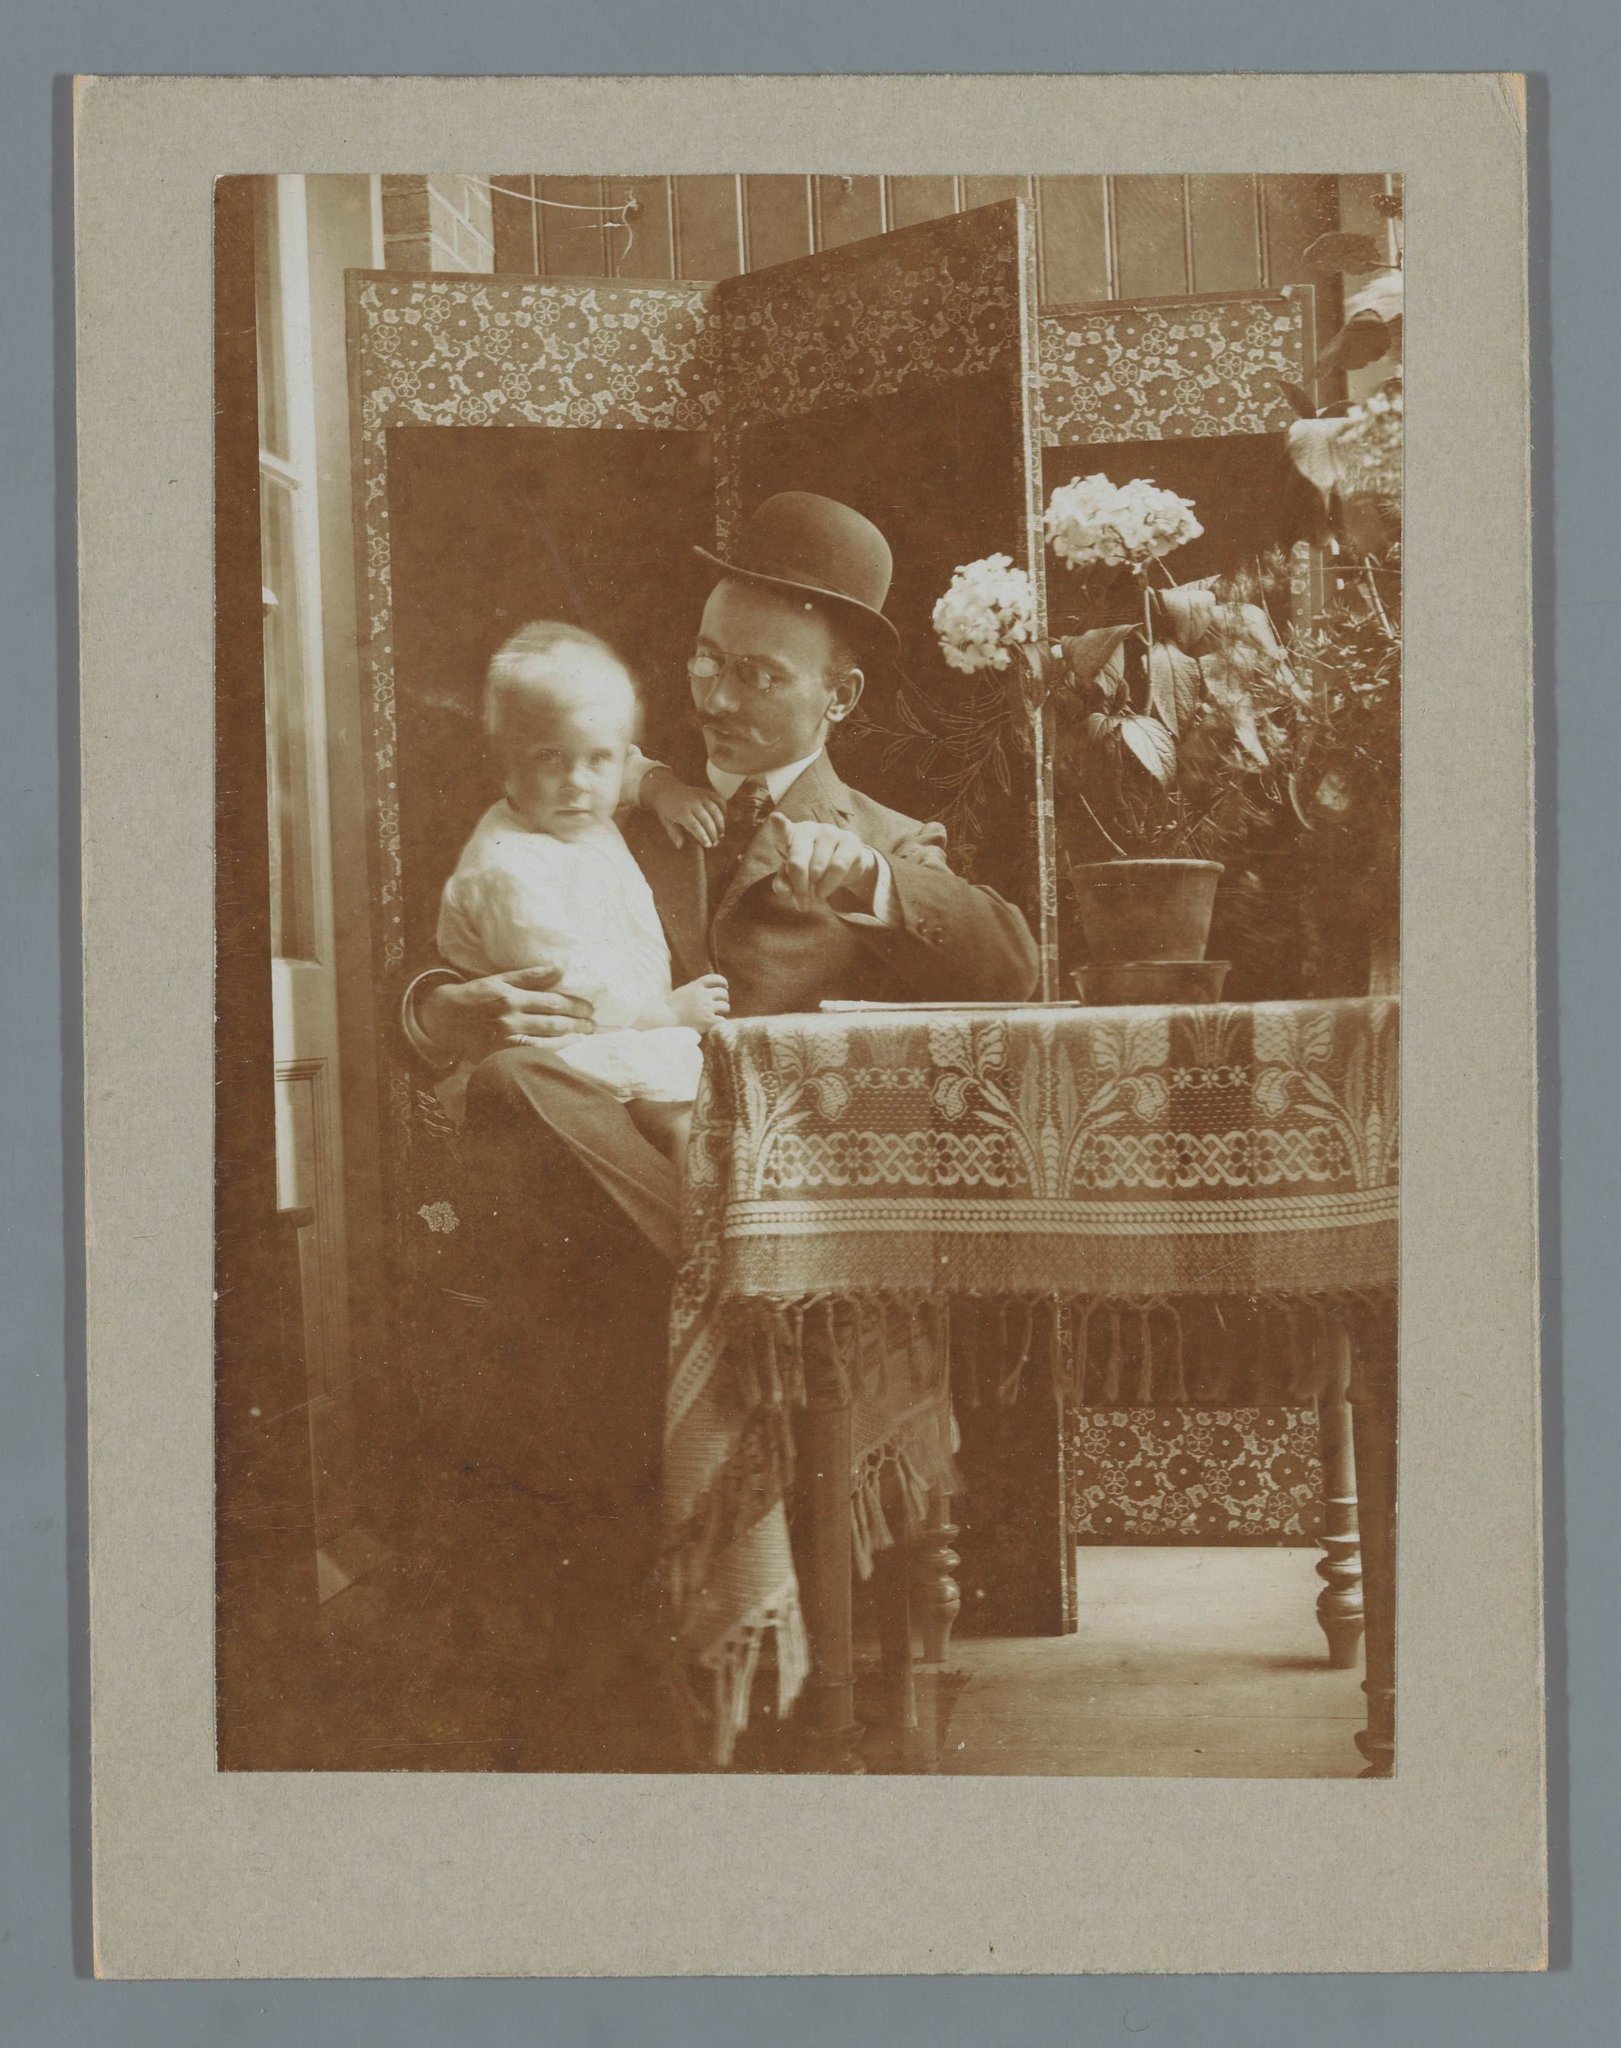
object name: photograph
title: Portret van een onbekende man met een kind op schoot voor een kamerscherm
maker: Anonymous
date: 1900-1915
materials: cardboard, photographic support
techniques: daylight paper print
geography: netherlands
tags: screen, folding screen, father and child(ren), man and child(ren) (family group)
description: RP-F-F20903 is op dezelfde plek genomen.